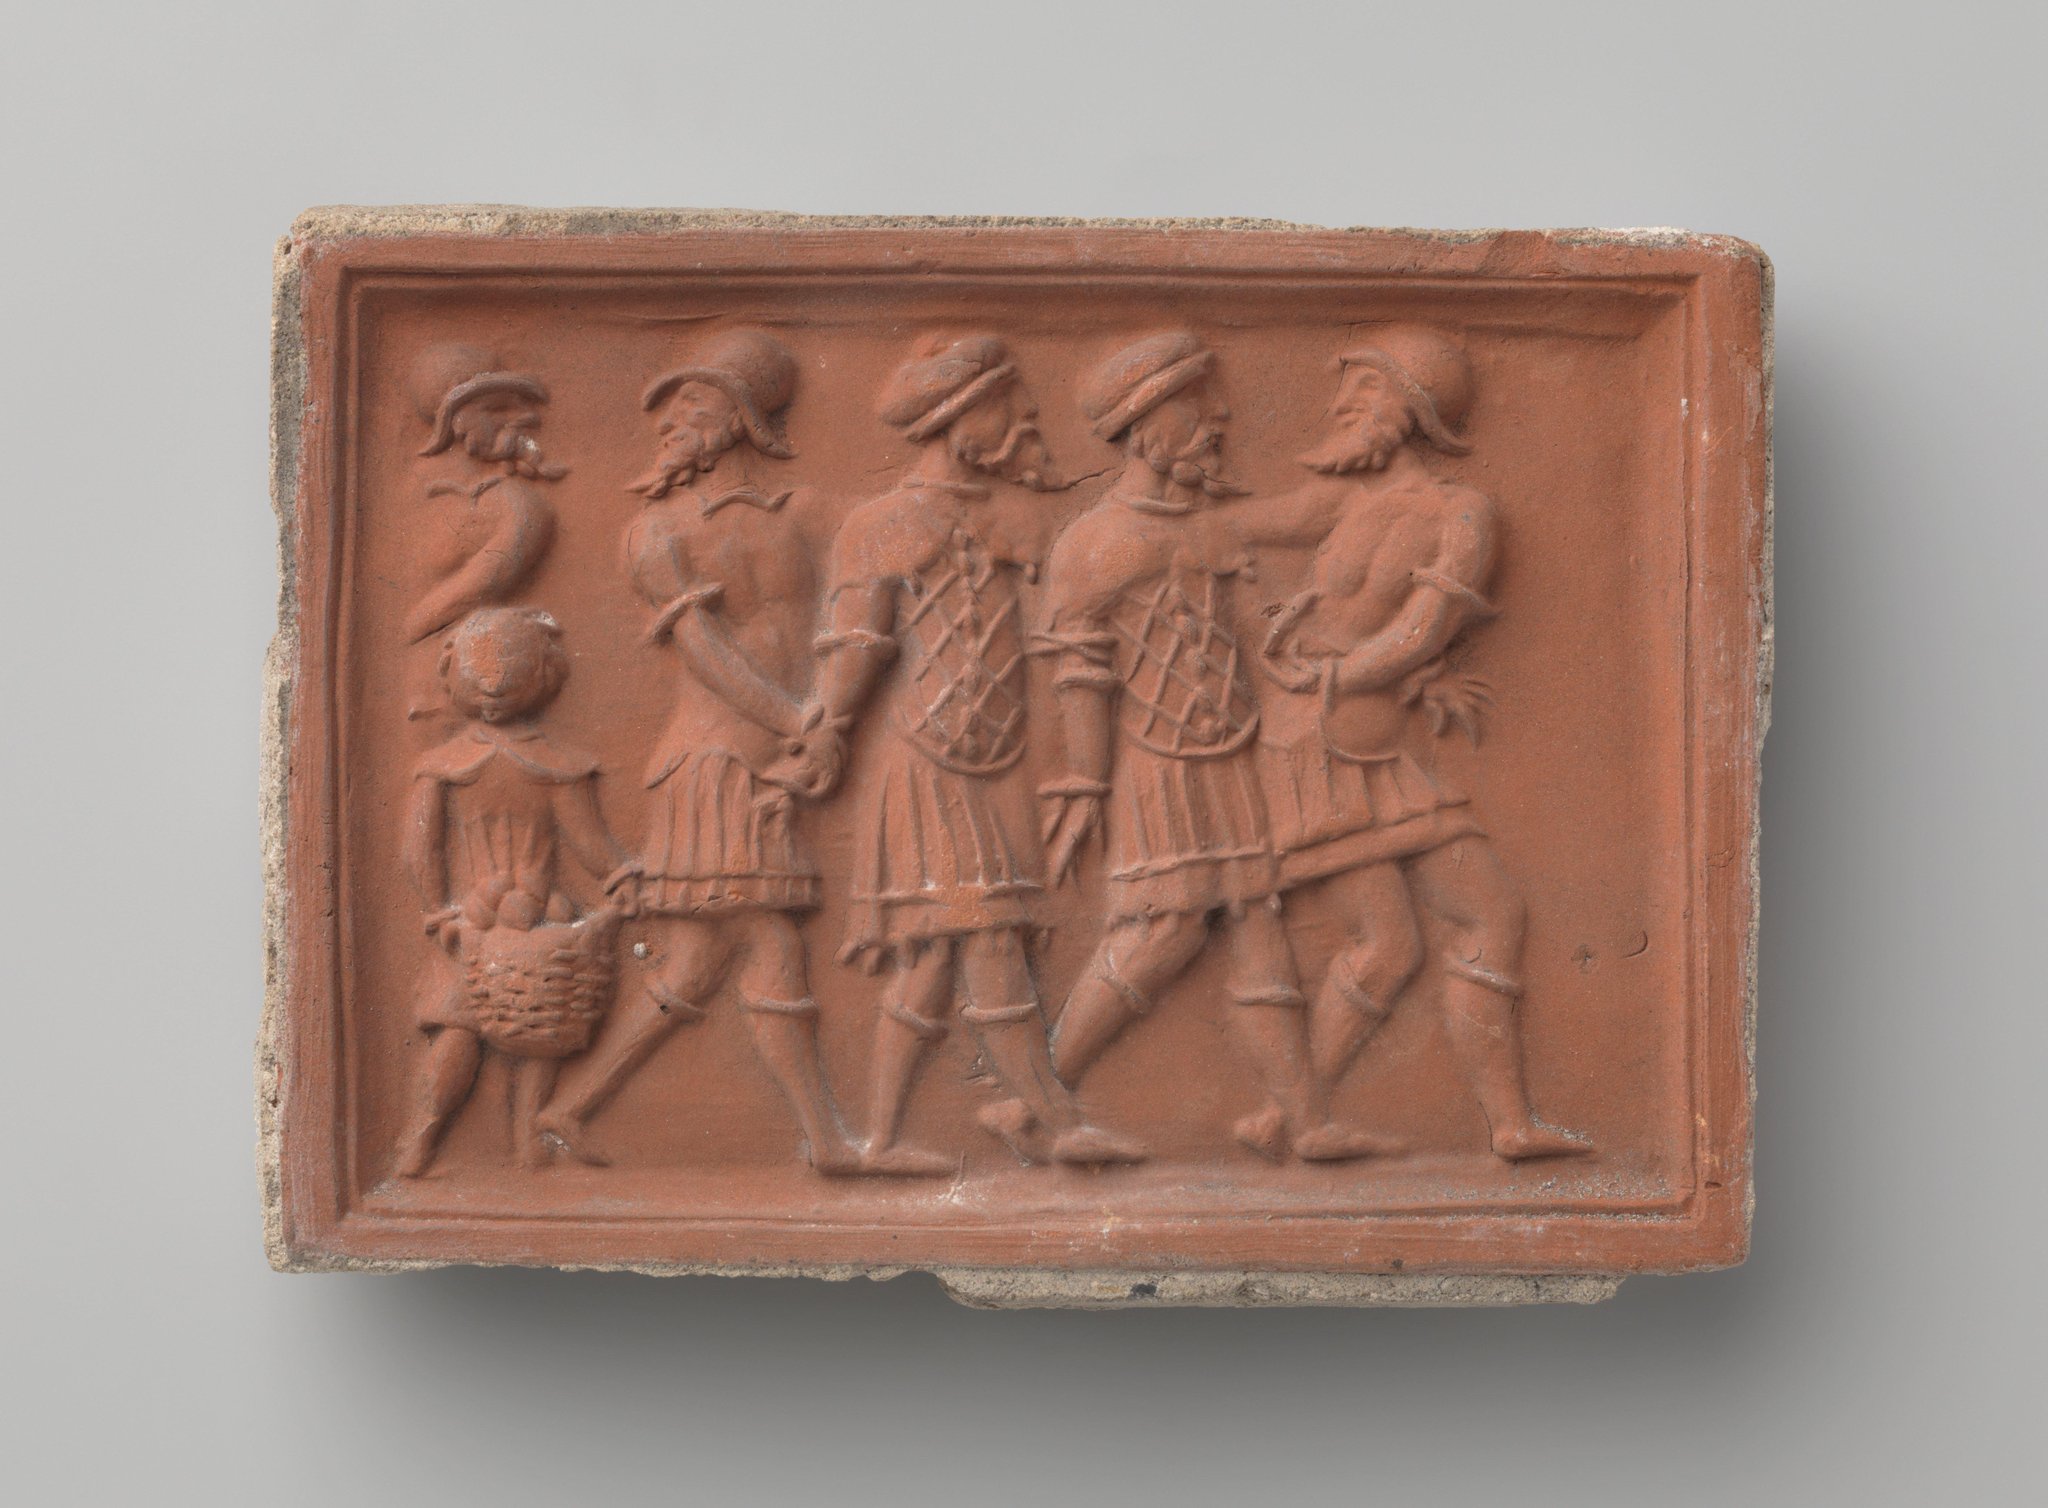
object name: hearthstone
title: Haardsteen met voorstelling van de beide ouderlingen uit de geschiedenis van Suzanna, die ter steniging worden weggeleid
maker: Anonymous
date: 1875-1900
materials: earthenware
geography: netherlands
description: Haardsteen met voorstelling van de beide ouderlingen uit de geschiedenis van Suzanna, die ter steniging worden weggeleid. Links draagt een jongen een mand met stenen aan.